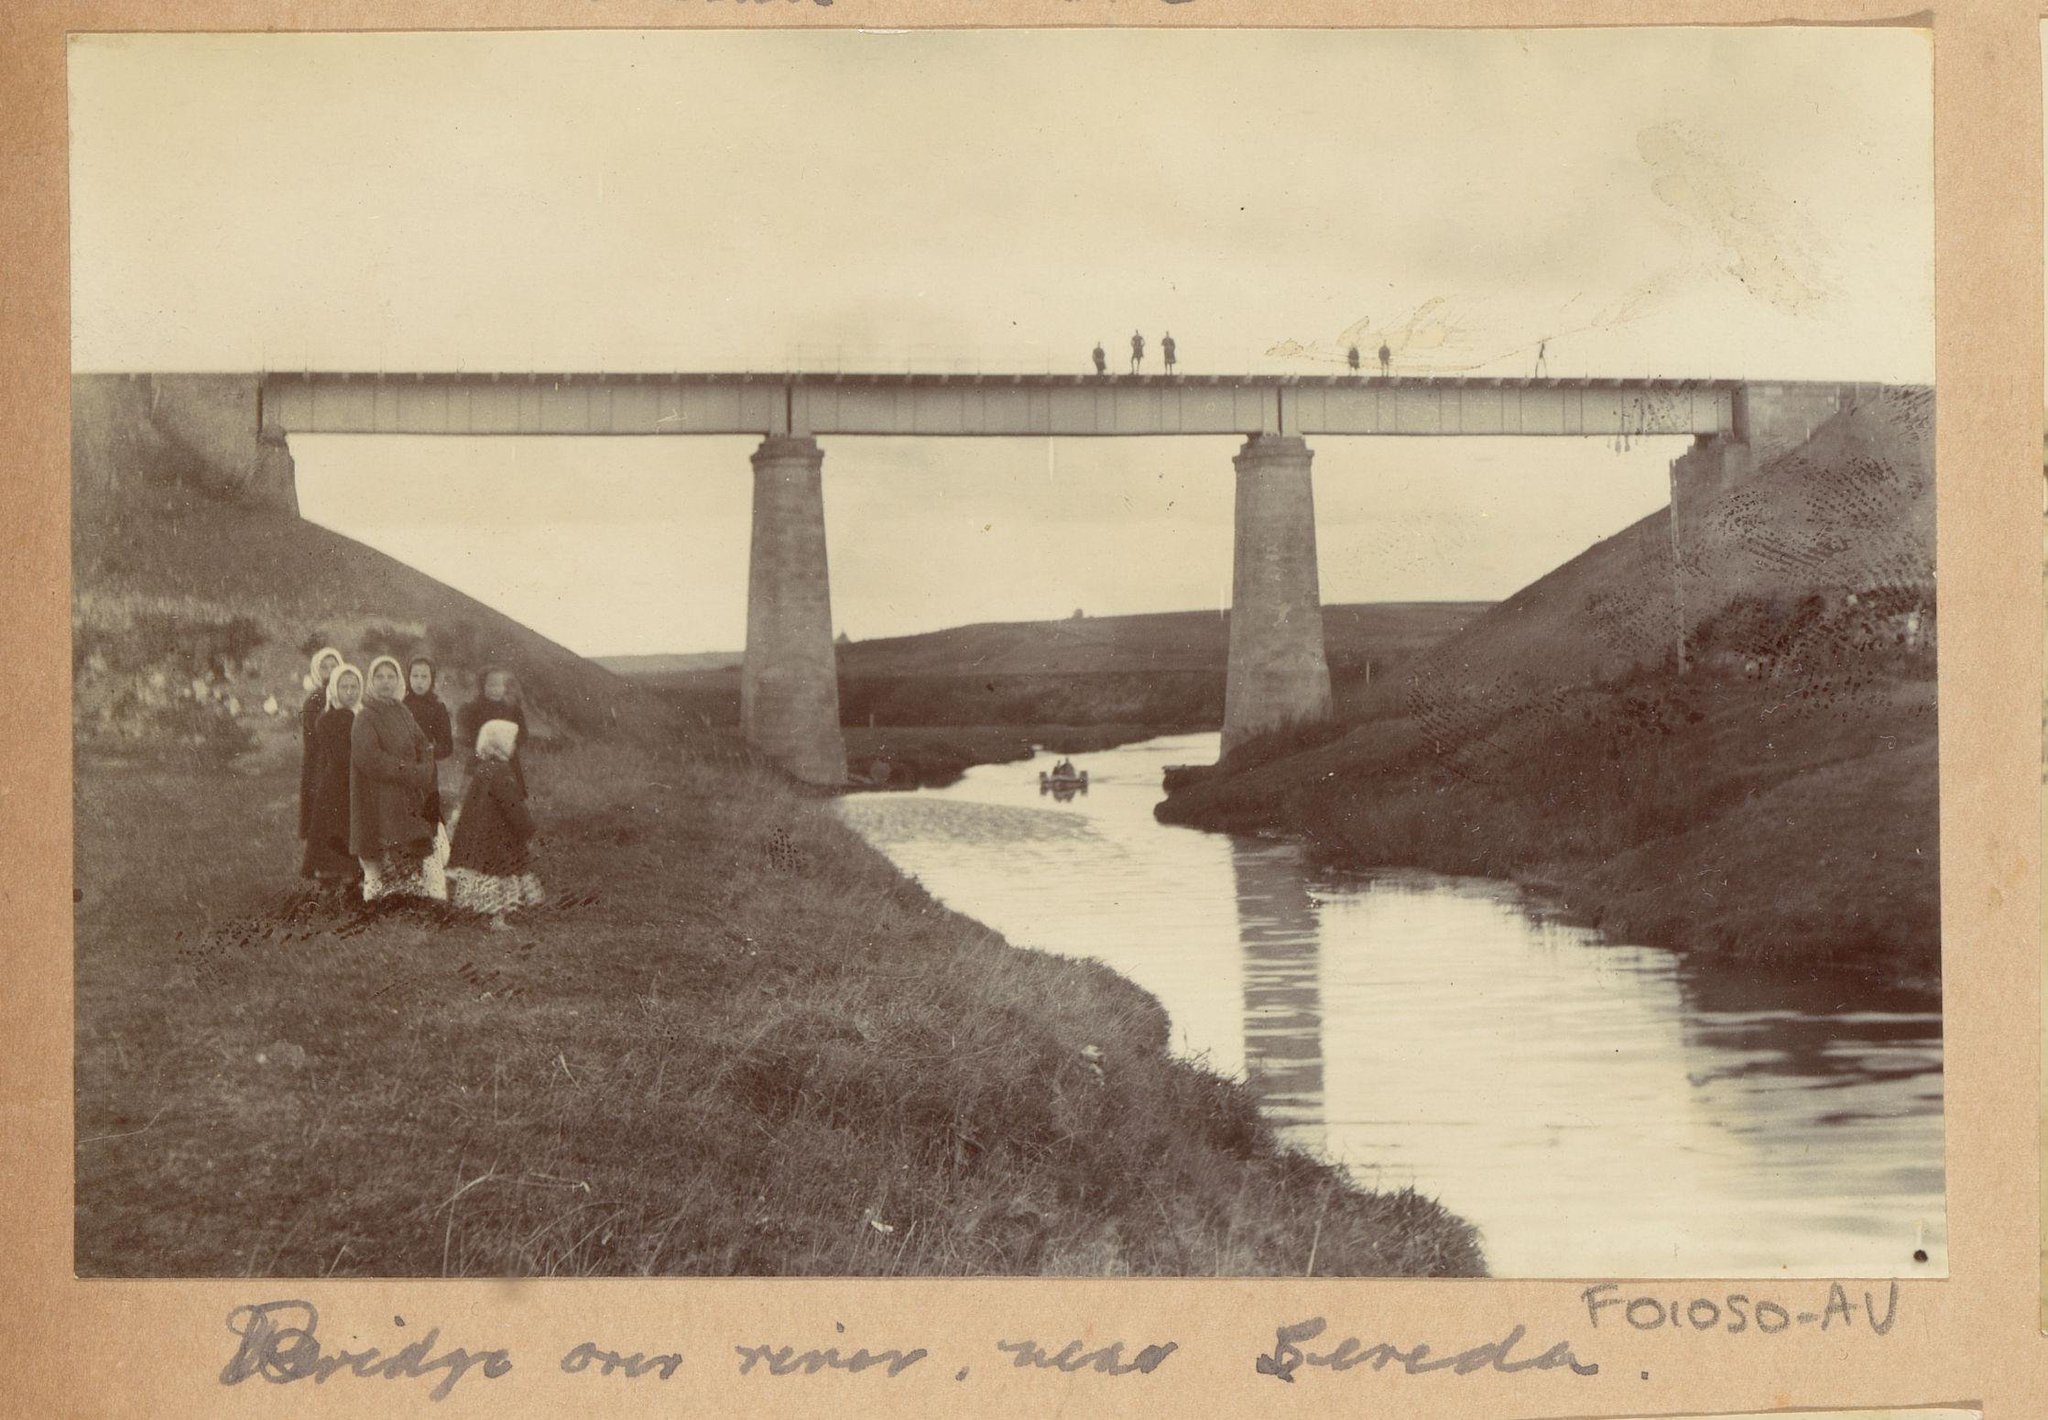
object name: photograph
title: Brug over een rivier bij Sereda, op de oever Russische meisjes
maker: joseph cheetham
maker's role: engineer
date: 1903-1904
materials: photographic support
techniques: gelatin silver print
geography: russia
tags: adolescent, young woman, maiden, landscape with bridge, viaduct or aqueduct, russia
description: Onderdeel van Fotoalbum van de Engelse familie Cheetham met opnames van hun verblijf in Rusland.